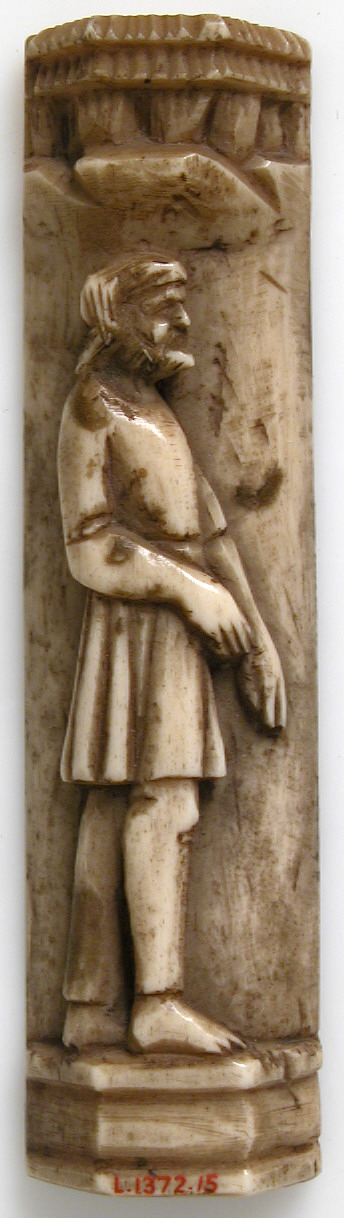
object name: panel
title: Panel with Bearded Man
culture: european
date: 1801-1900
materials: bone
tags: profiles